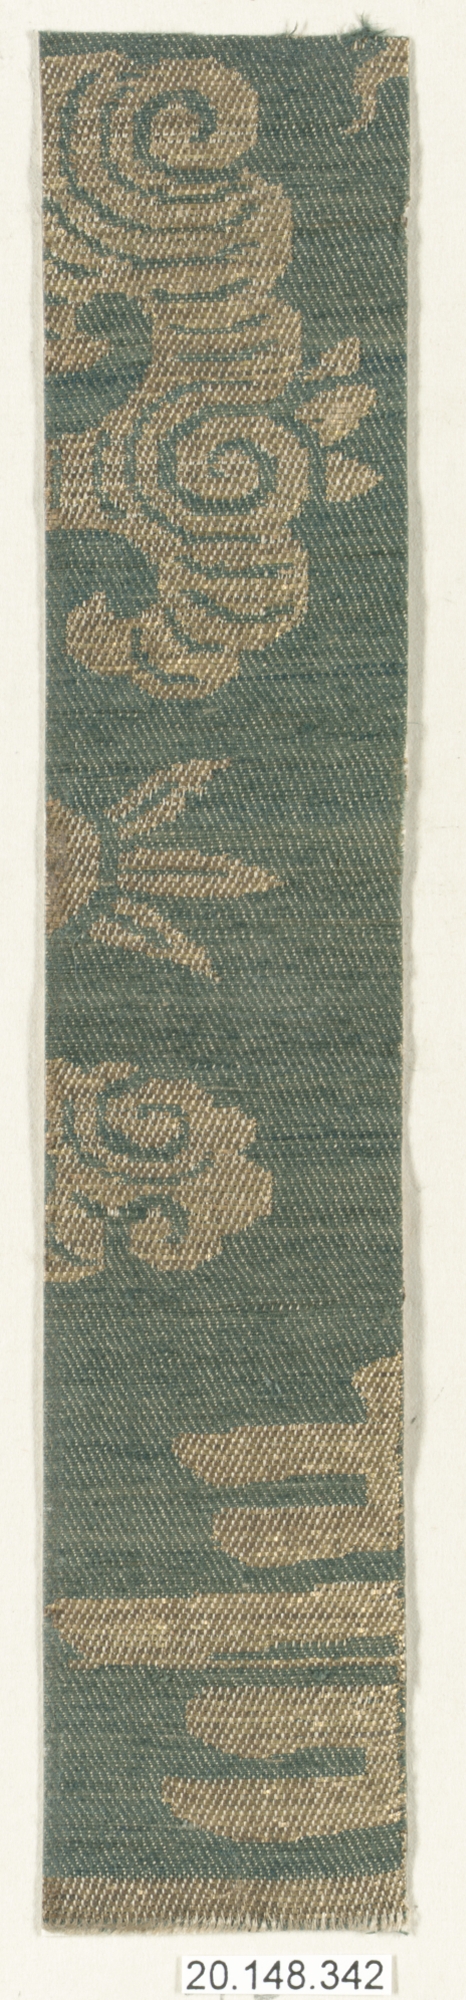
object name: piece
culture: chinese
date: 1701-1800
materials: silk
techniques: compound weave